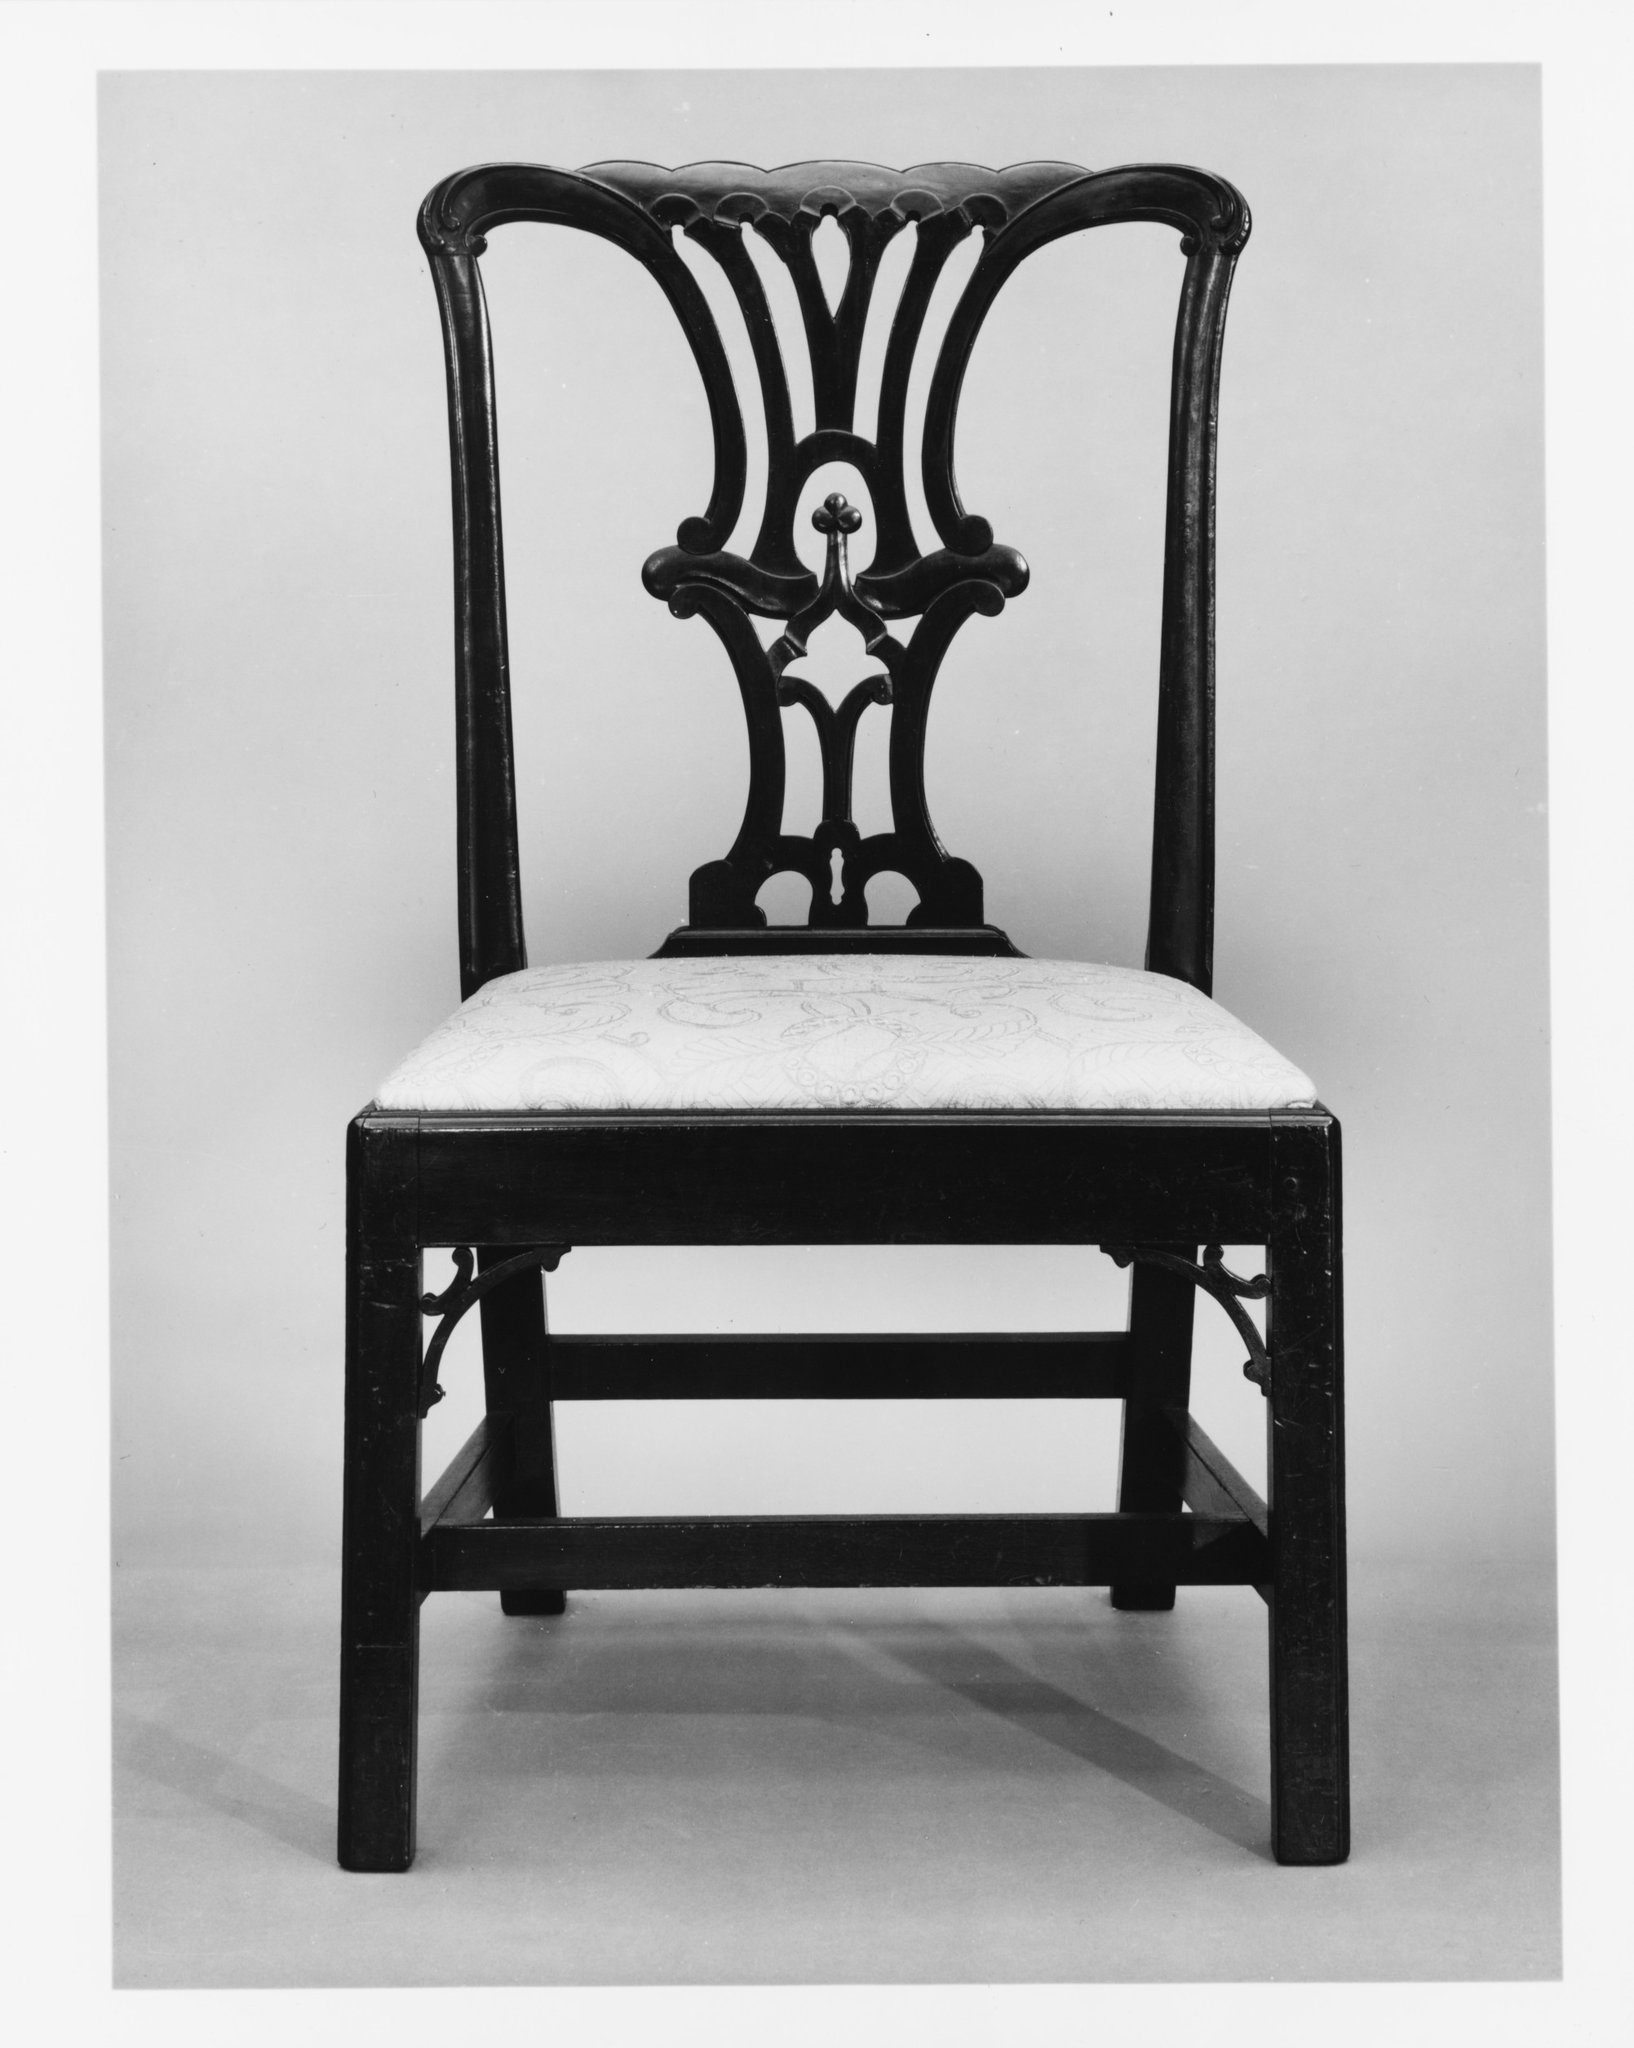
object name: side chair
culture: american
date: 1765-1790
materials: wood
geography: united states